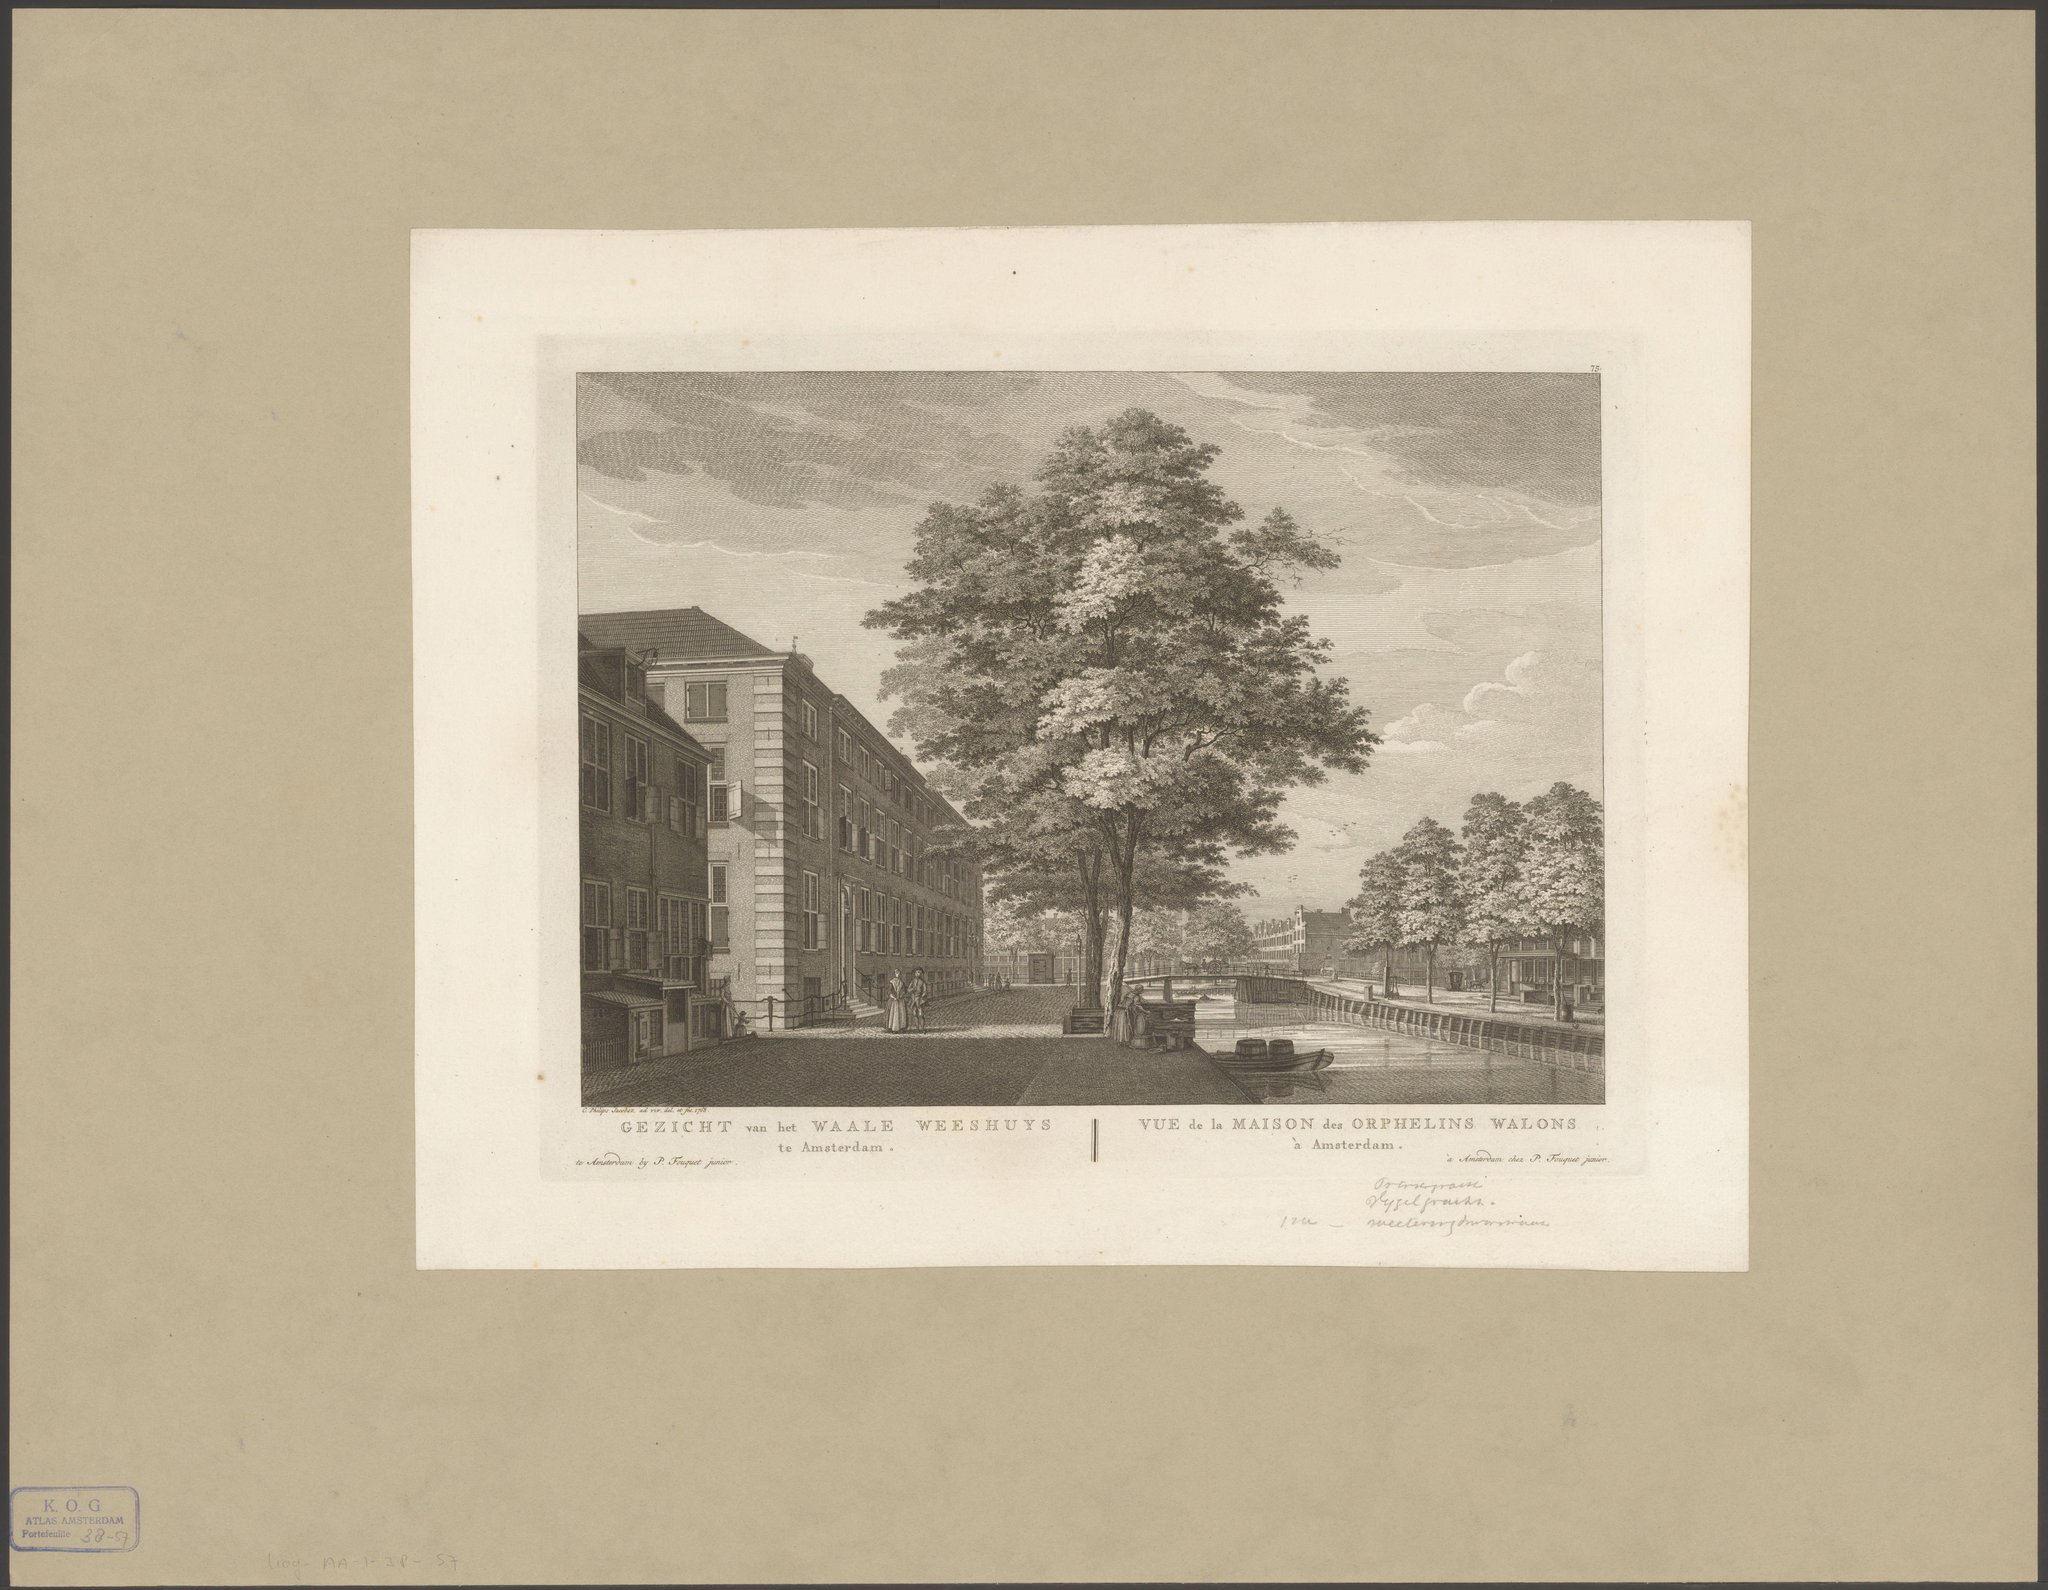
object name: print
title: Atlas van Fouquet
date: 1768-1783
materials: paper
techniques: engraving, etching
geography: amsterdam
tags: bridge in city across river, canal, etc. (+ city(-scape) with figures, staffage), orphanage, canals, waters (in city) (+ city(-scape) with figures, staffage)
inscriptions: collector's mark: Lugt 1641b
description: Vanaf 1760 gaf Pierre Fouquet stadsgezichten van Amsterdam naar tekeningen van verschillende kunstenaars uit. Deze prenten werden aanvankelijk los verkocht. Later werden ze samengebonden verkocht in verschillende volgordes en aantallen in: (1). Afbeeldingen van de wyd-vermaarde koopstad Amsterdam benevens des zelvs voornaamste gebouwen en gezigten alle naar het leeven getekend / Receuil des edifices les plus considerables et des plus belles vues, de la fameuse ville d'Amsterdam, dessinées d'après nature. Amsterdam: Pierre Fouquet, 1778-1783. Deze 'uitgave' bestond waarschijnlijk alleen uit een titelblad en inhoudsopgave van de tot dusver 100 uitgegeven prenten, die de koper zelf aan zijn of haar reeds verzamelde prenten kon toevoegen. De hoeveelheid en volgorde van prenten verzameld onder deze titel verschilt dus sterk. (2). Nieuwe atlas, van de voornaamste gebouwen en gezigten der stad Amsterdam, met derzelver beknopte beschryvingen. 2 dln. Amsterdam: Daniël Jean Changuion en Petrus den Hengst [in opdracht van Pierre Fouquet], 1783. Ook werden er door verschillende uitgevers tussen 1788 (Amsterdam: Petrus Conradi) en 1805 (Amsterdam: Evert Maaskamp) heruitgaven gepubliceerd.